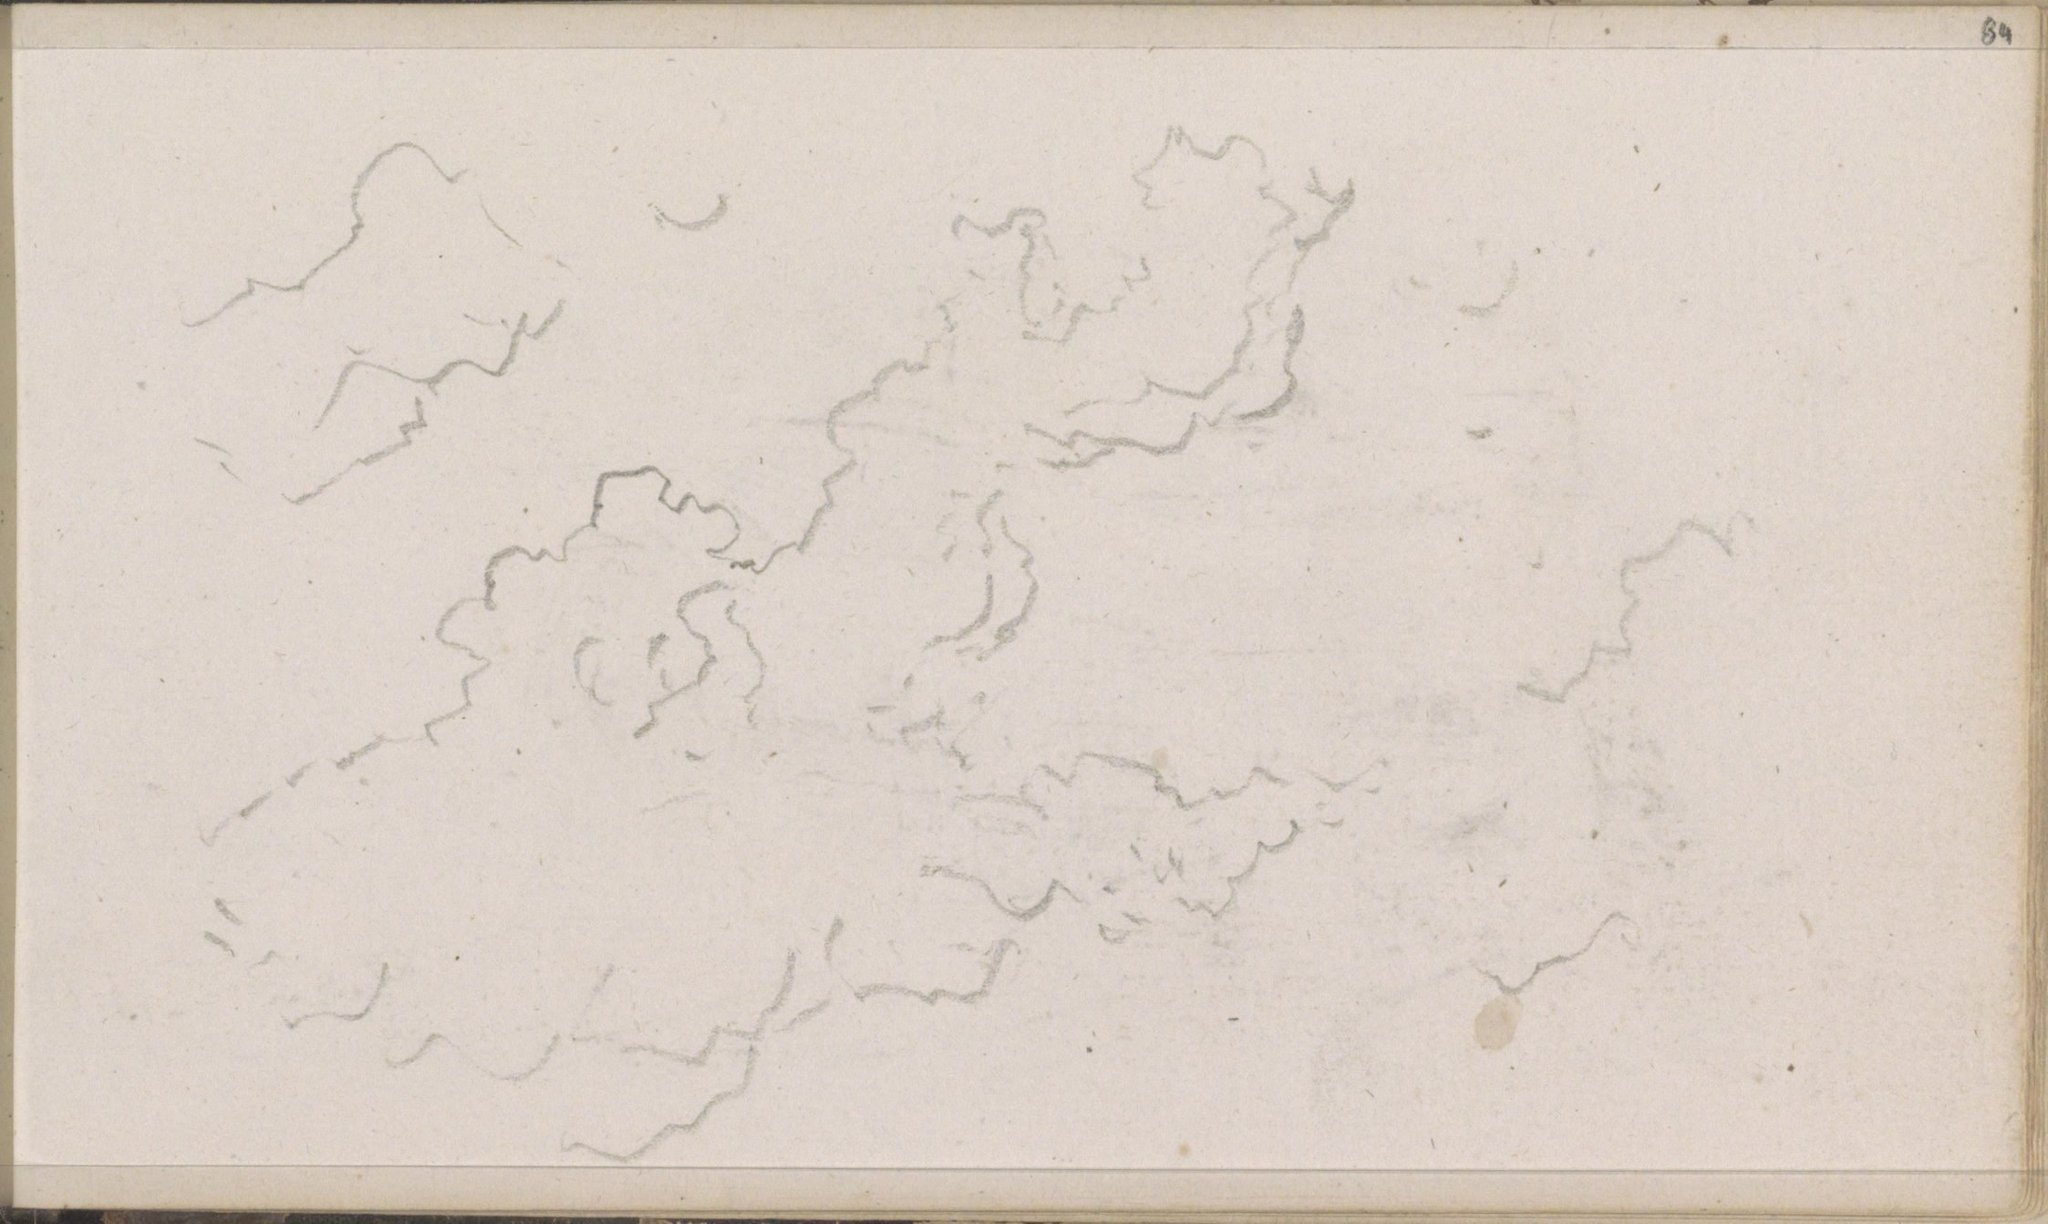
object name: sketchbook leaf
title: Wolken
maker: johannes tavenraat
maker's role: draughtsman, painter, print maker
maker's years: 1809-1881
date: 1864-1880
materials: paper, pencil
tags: clouds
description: Blad 84 recto uit een schetsboek met 98 bladen.